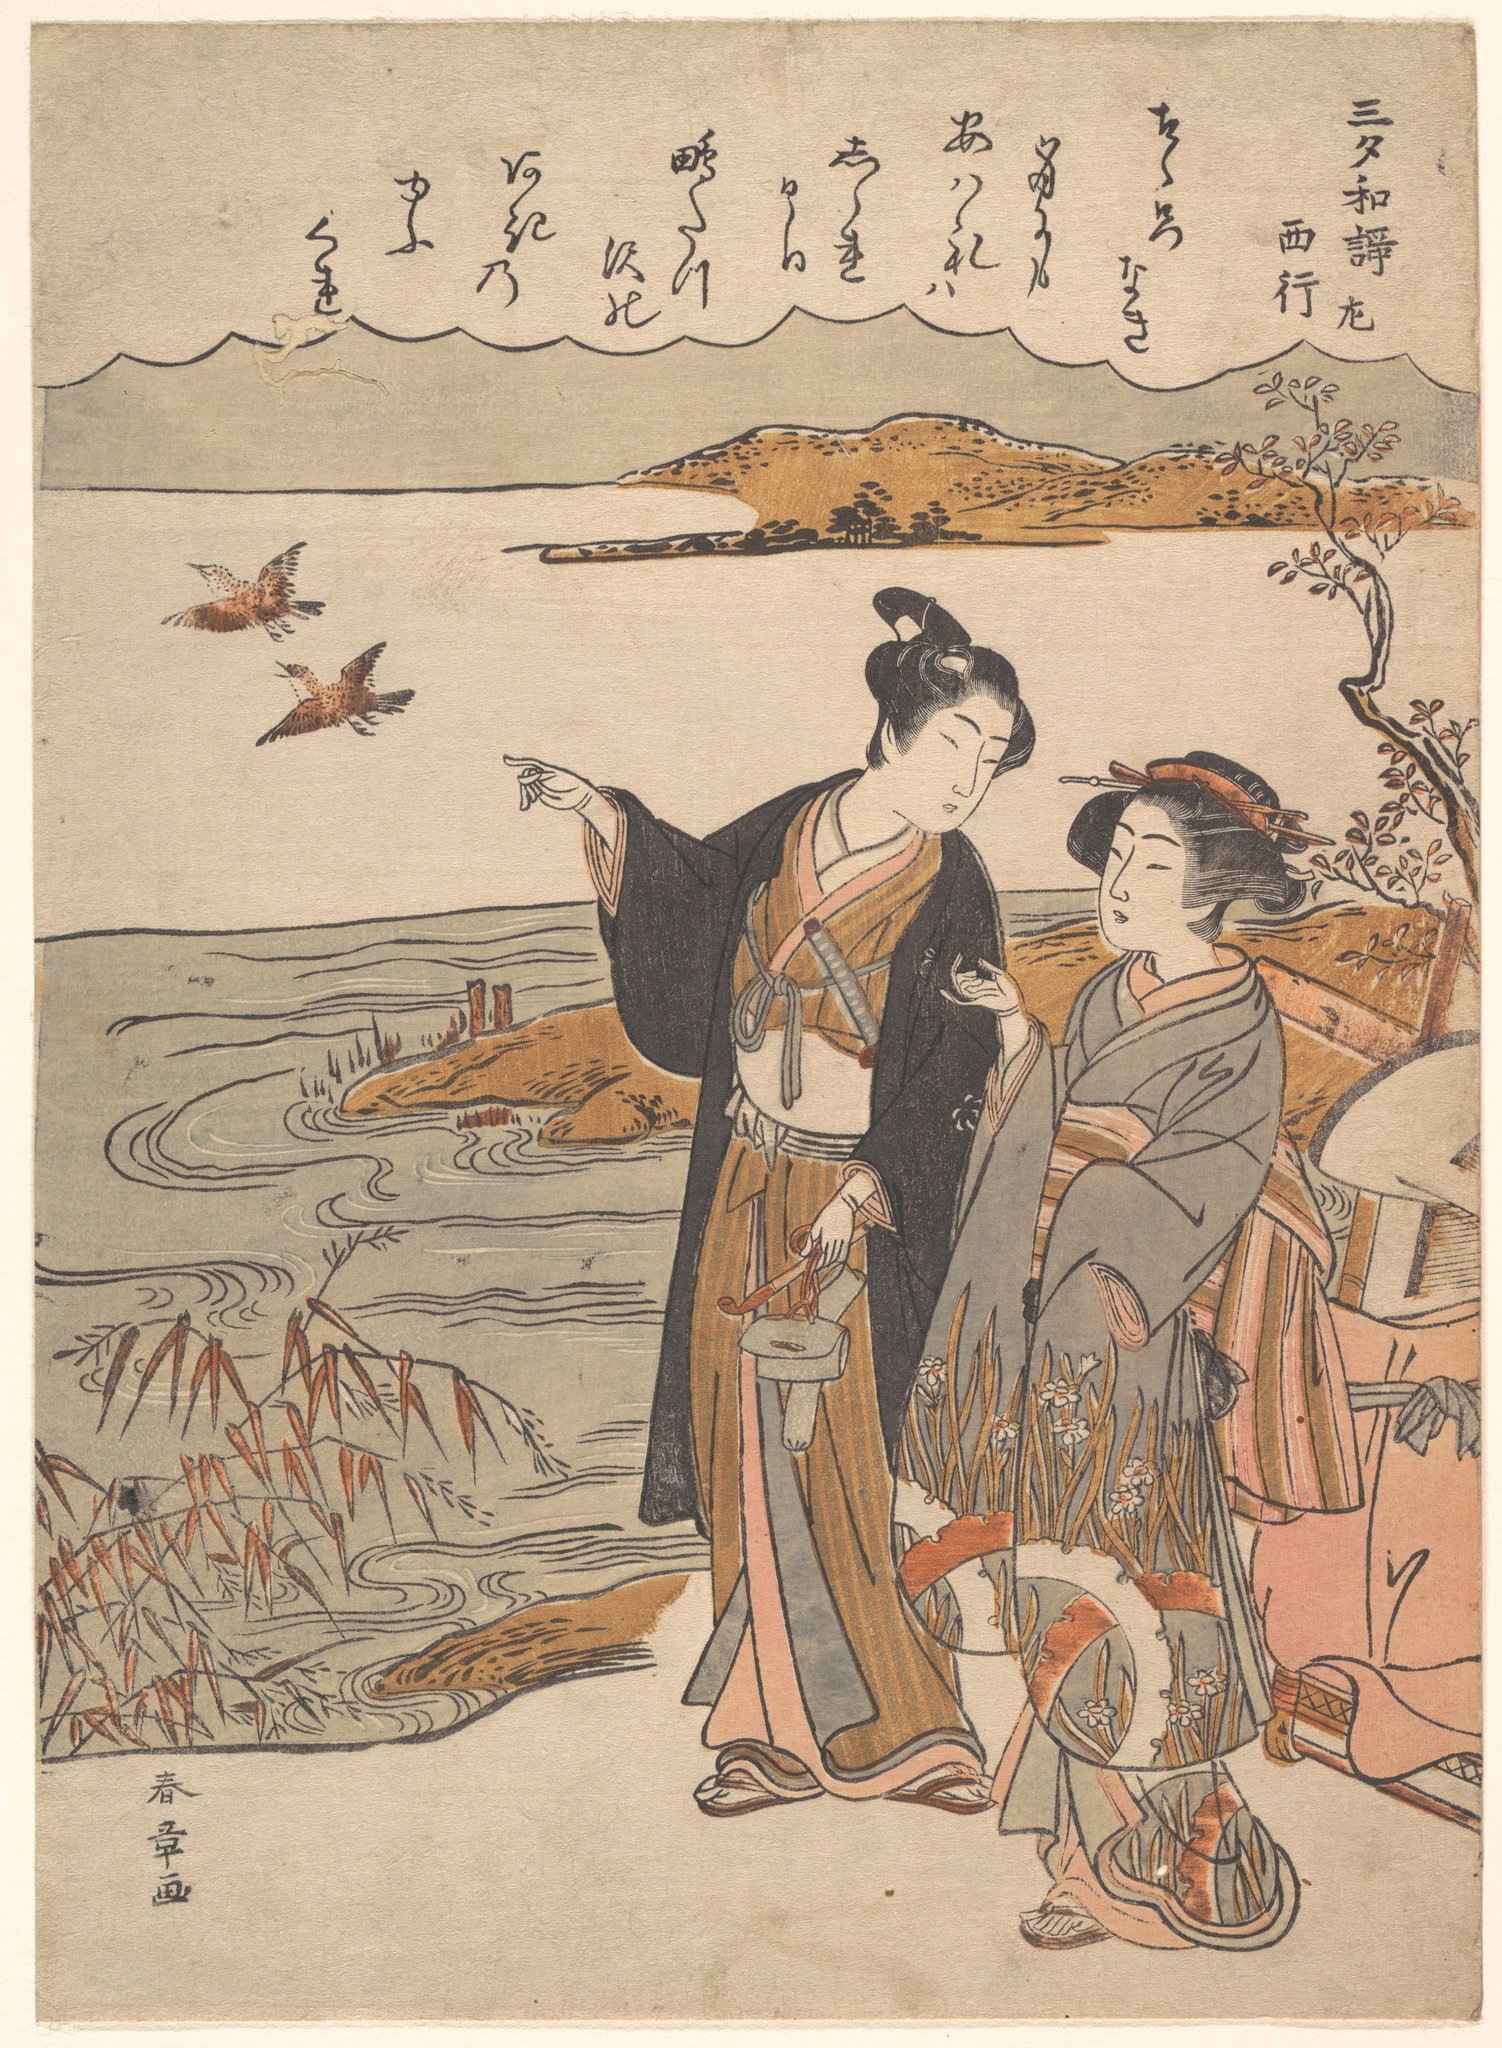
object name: woodblock print nishiki e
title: Autumn Evening ( A Poem by Saigyō), from the series Sanseki waka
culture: japanese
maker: katsukawa shunshō 勝川春章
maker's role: artist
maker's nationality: japanese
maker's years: 1726-1792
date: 1767-1800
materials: ink, paper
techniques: nishiki e, woodblock print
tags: birds,men,women,leaves,evening